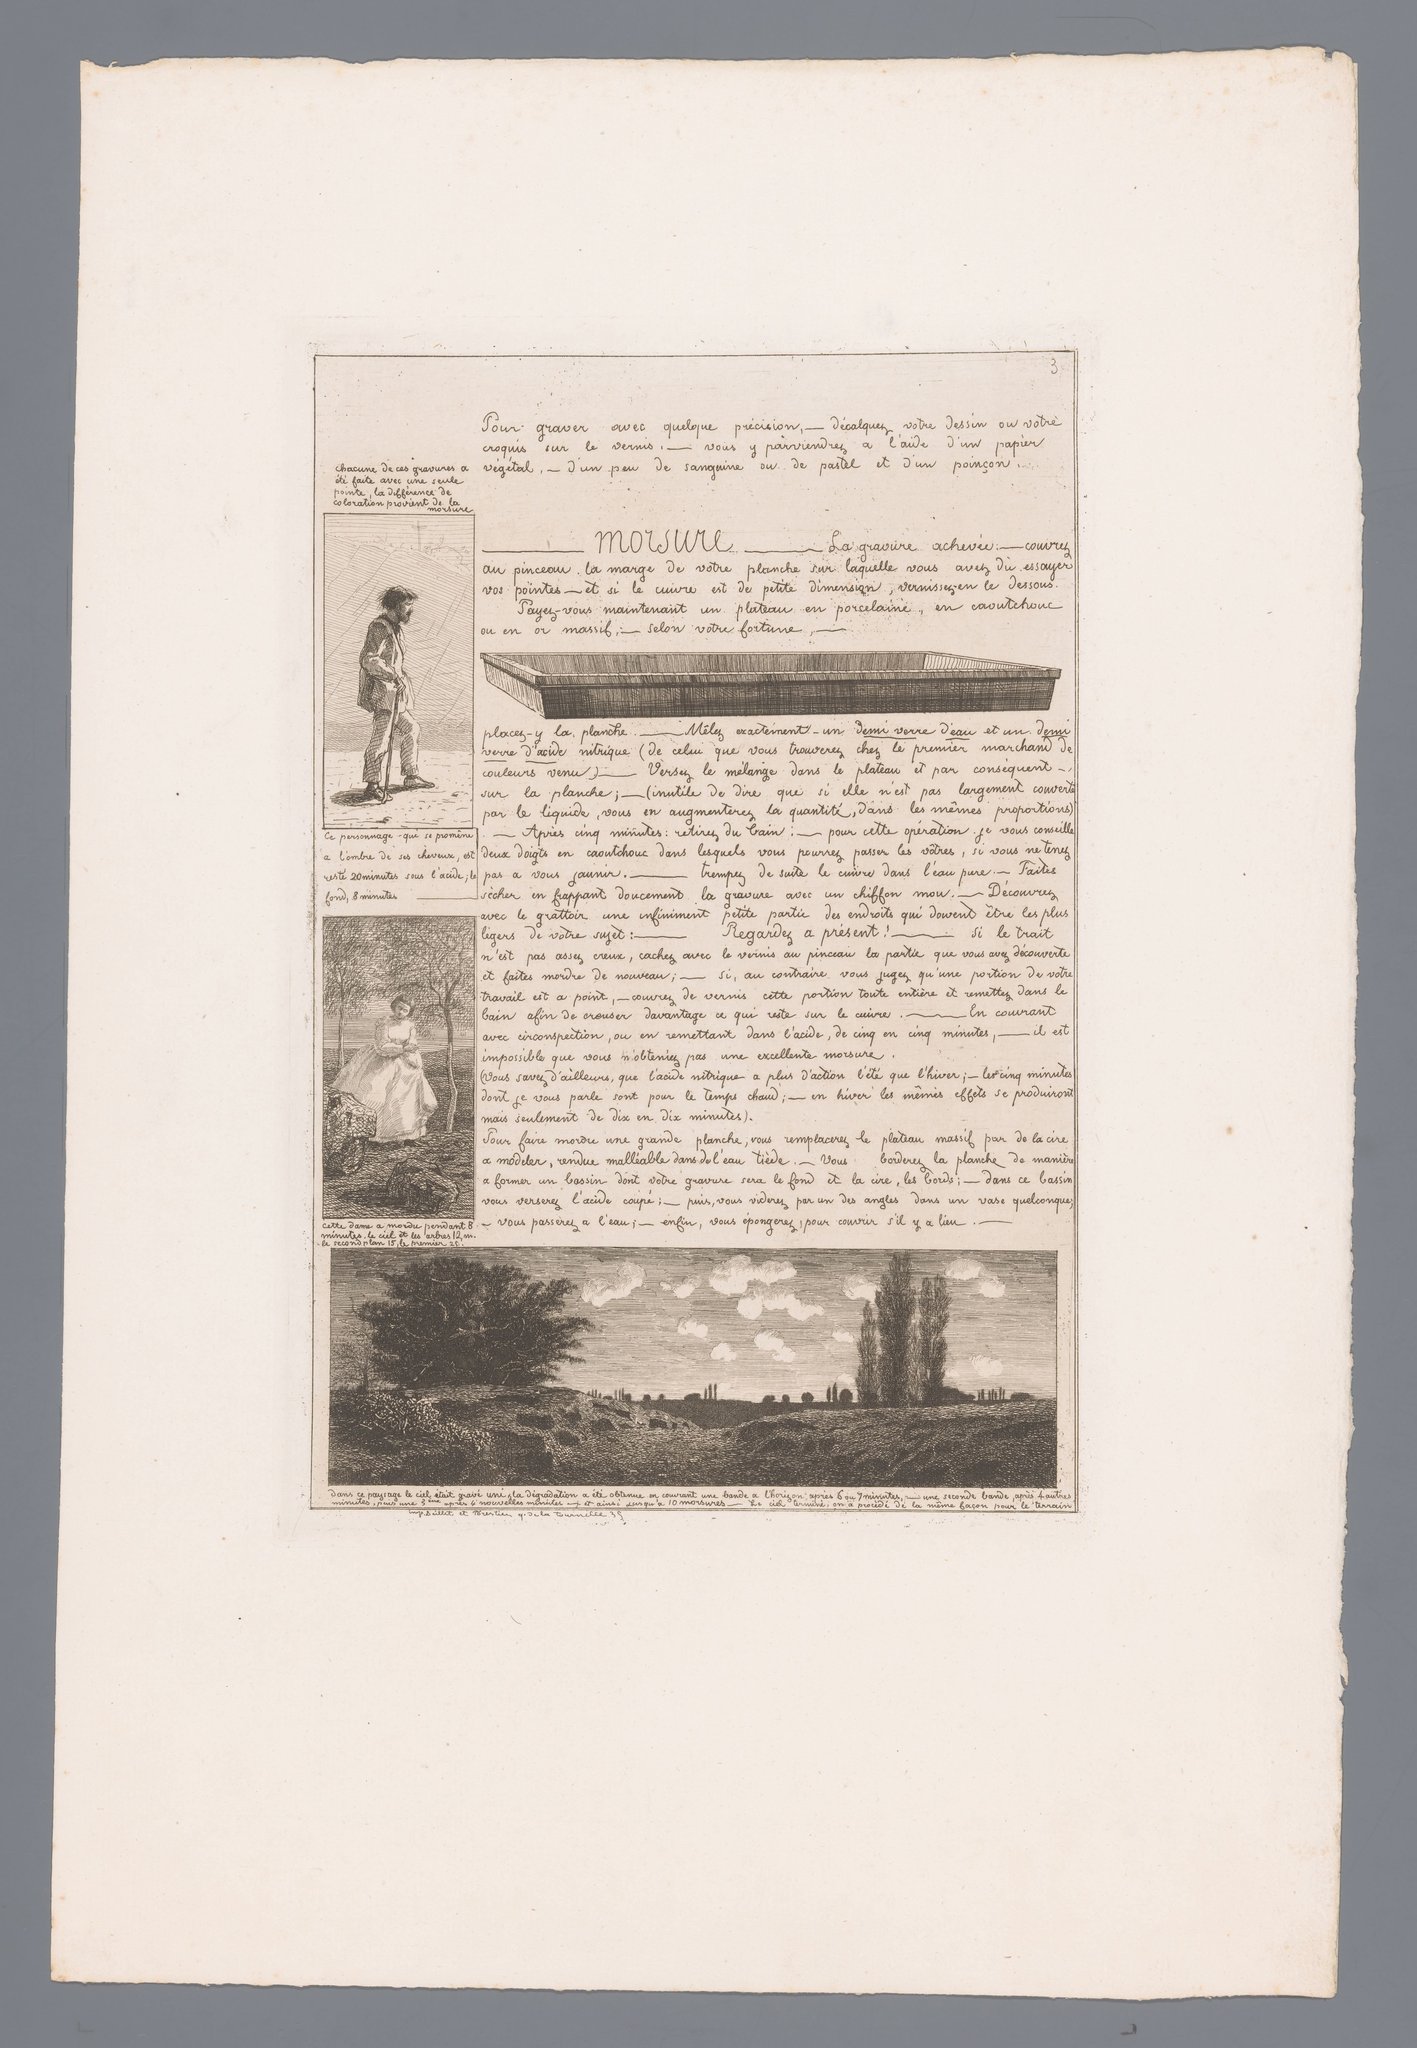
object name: print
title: Brief over etstechnieken met illustratie van een etsbad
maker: adolphe martial potémont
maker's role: print maker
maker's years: 1828-1883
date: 1864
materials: paper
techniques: etching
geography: paris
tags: etching, letter, envelope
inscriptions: collector's mark: Lugt 2228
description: Rond de tekst voorbeelden van etsen: een man, een vrouw en een landschap, met daarbij vermeld de tijden dat ze in het etsbad hebben gelegen. Deze prent maakt deel uit van een omslag met 4 prenten.